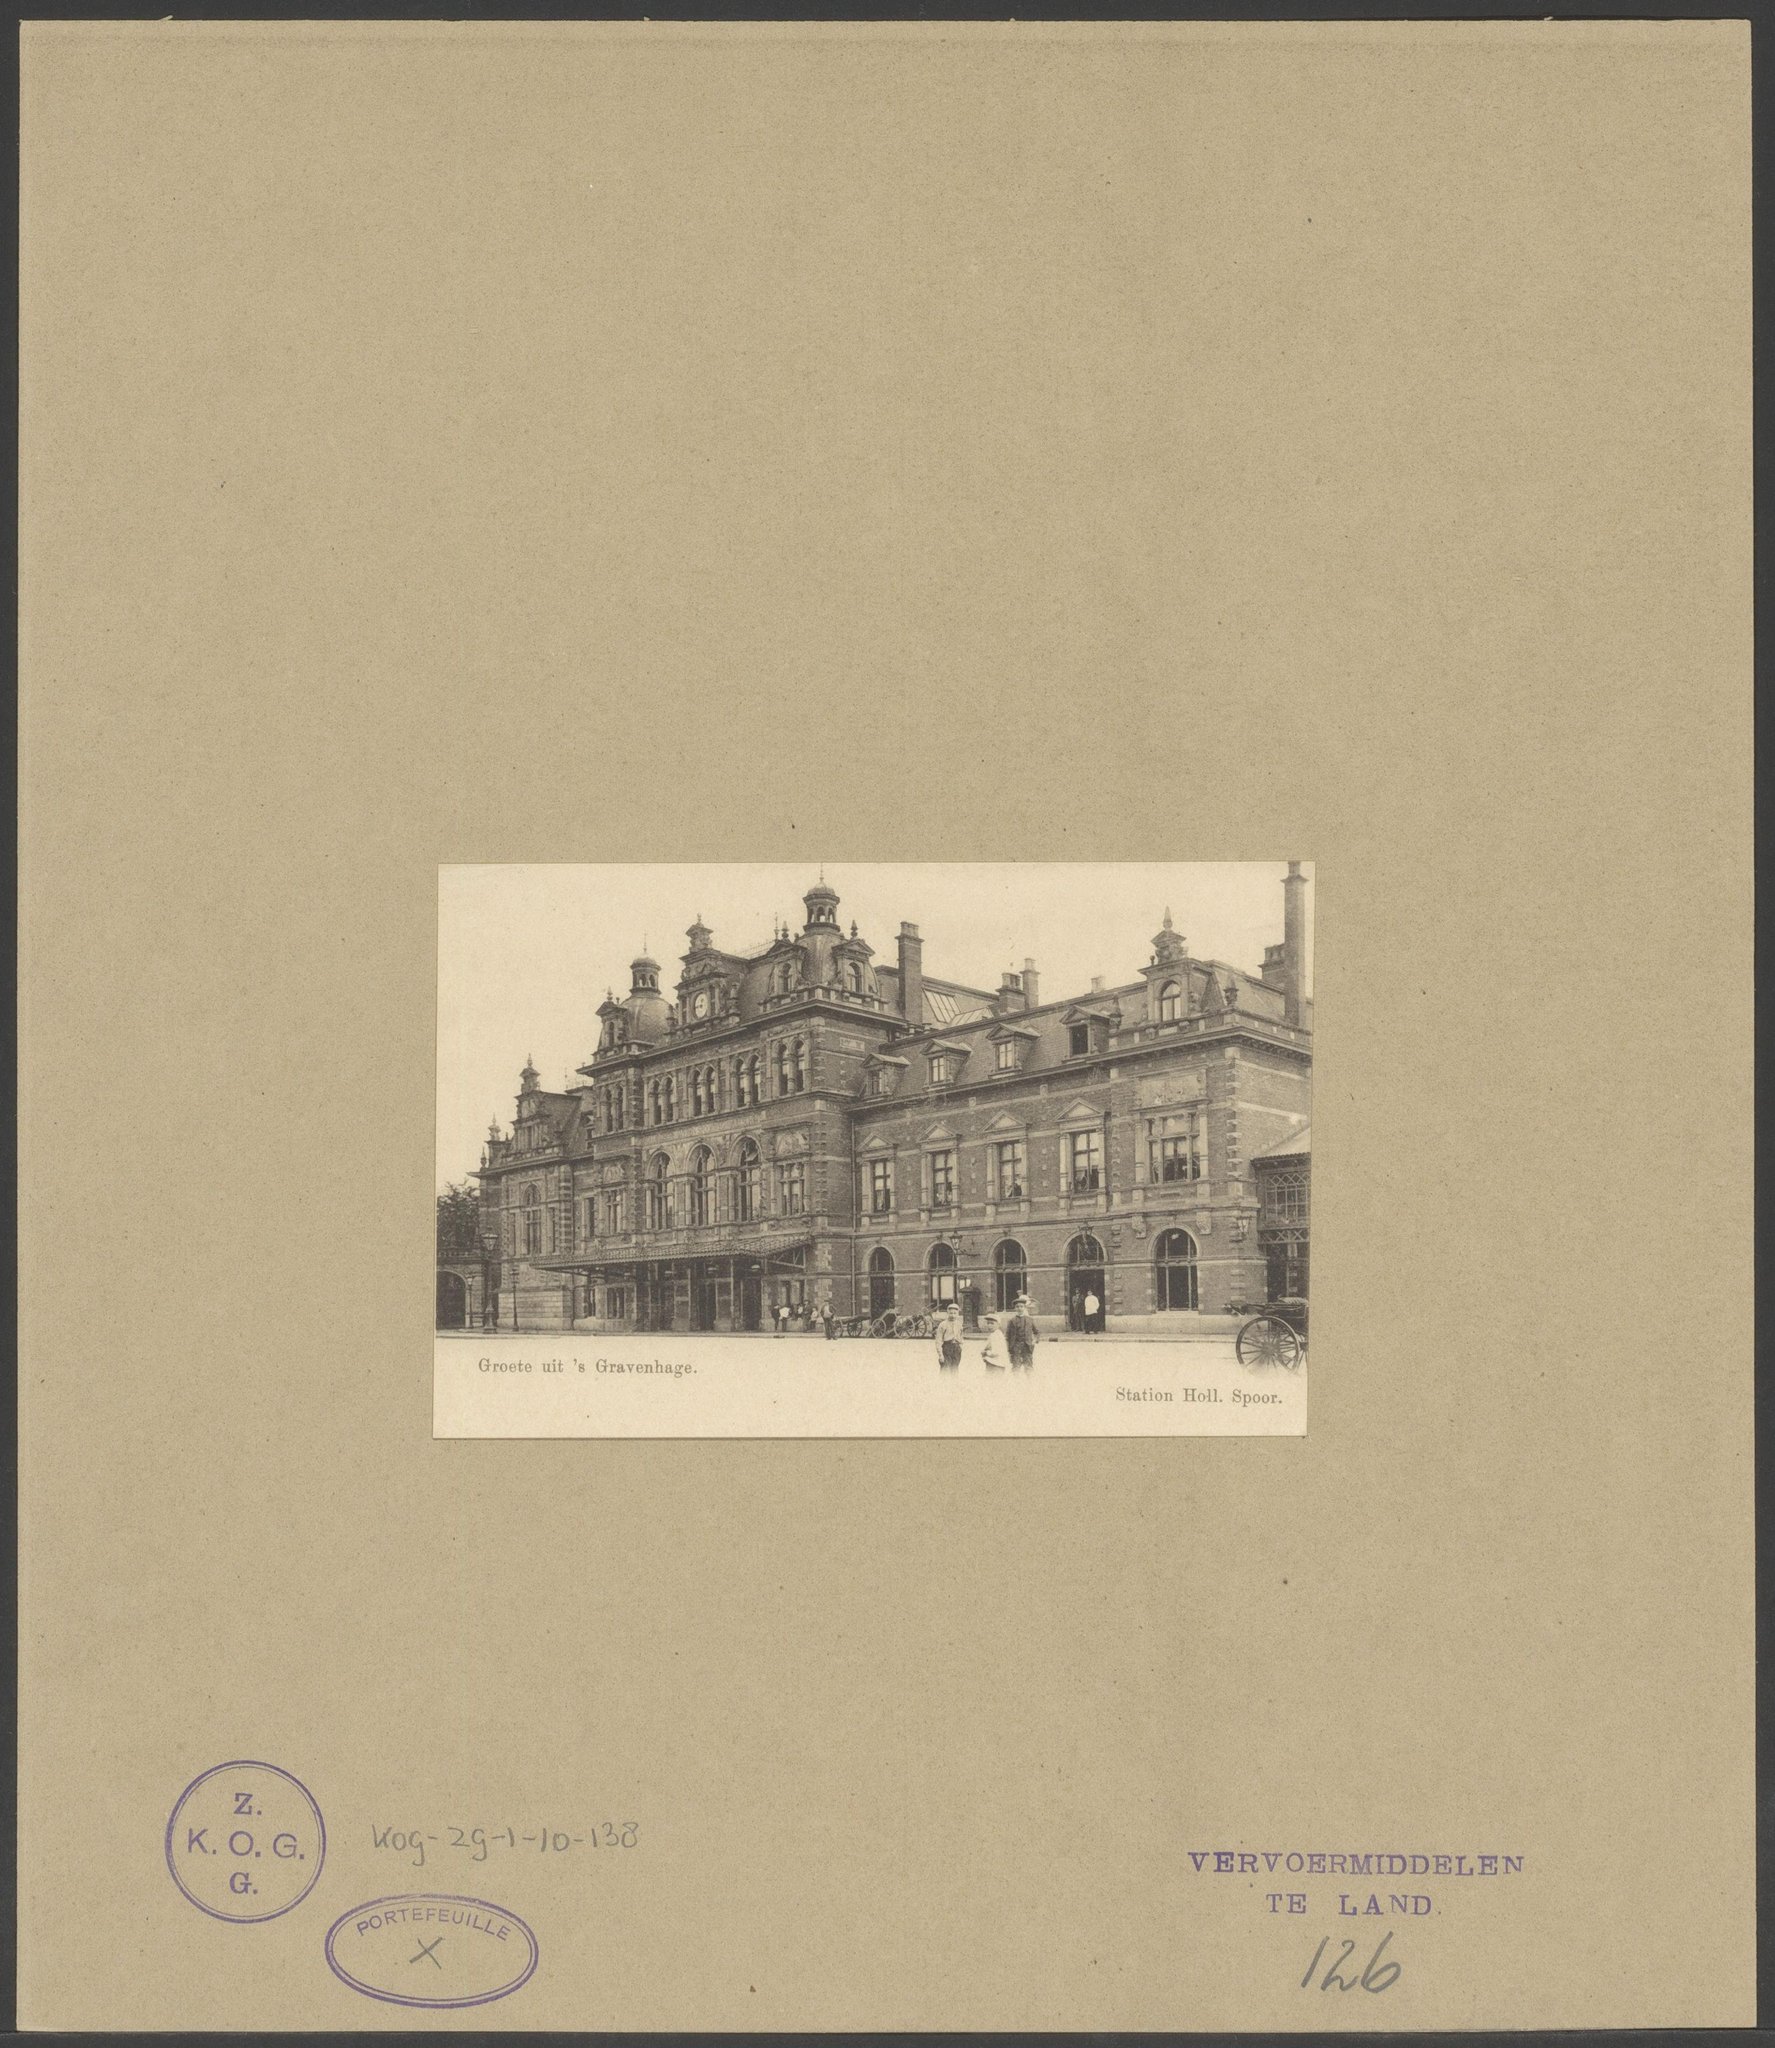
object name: photomechanical print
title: Station Hollands Spoor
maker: Anonymous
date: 1900-1920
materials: paper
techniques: photograph, letterpress printing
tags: station; shelter (railway, tramway), the hague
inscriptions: collector's mark: Lugt 1641, stamp, stamp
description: Station Den Haag HS. Rechtsonder de tekst: Groete uit 's Gravenhage. Tekst linksonder: Station Holl. Spoor. Onderwerpsrubrieken binnen de Atlas Zeden en Gewoonten: Handel, nijverheid en verkeer, Vervoermiddelen te land en te water, vervoermiddelen te land, Spoorwegen.